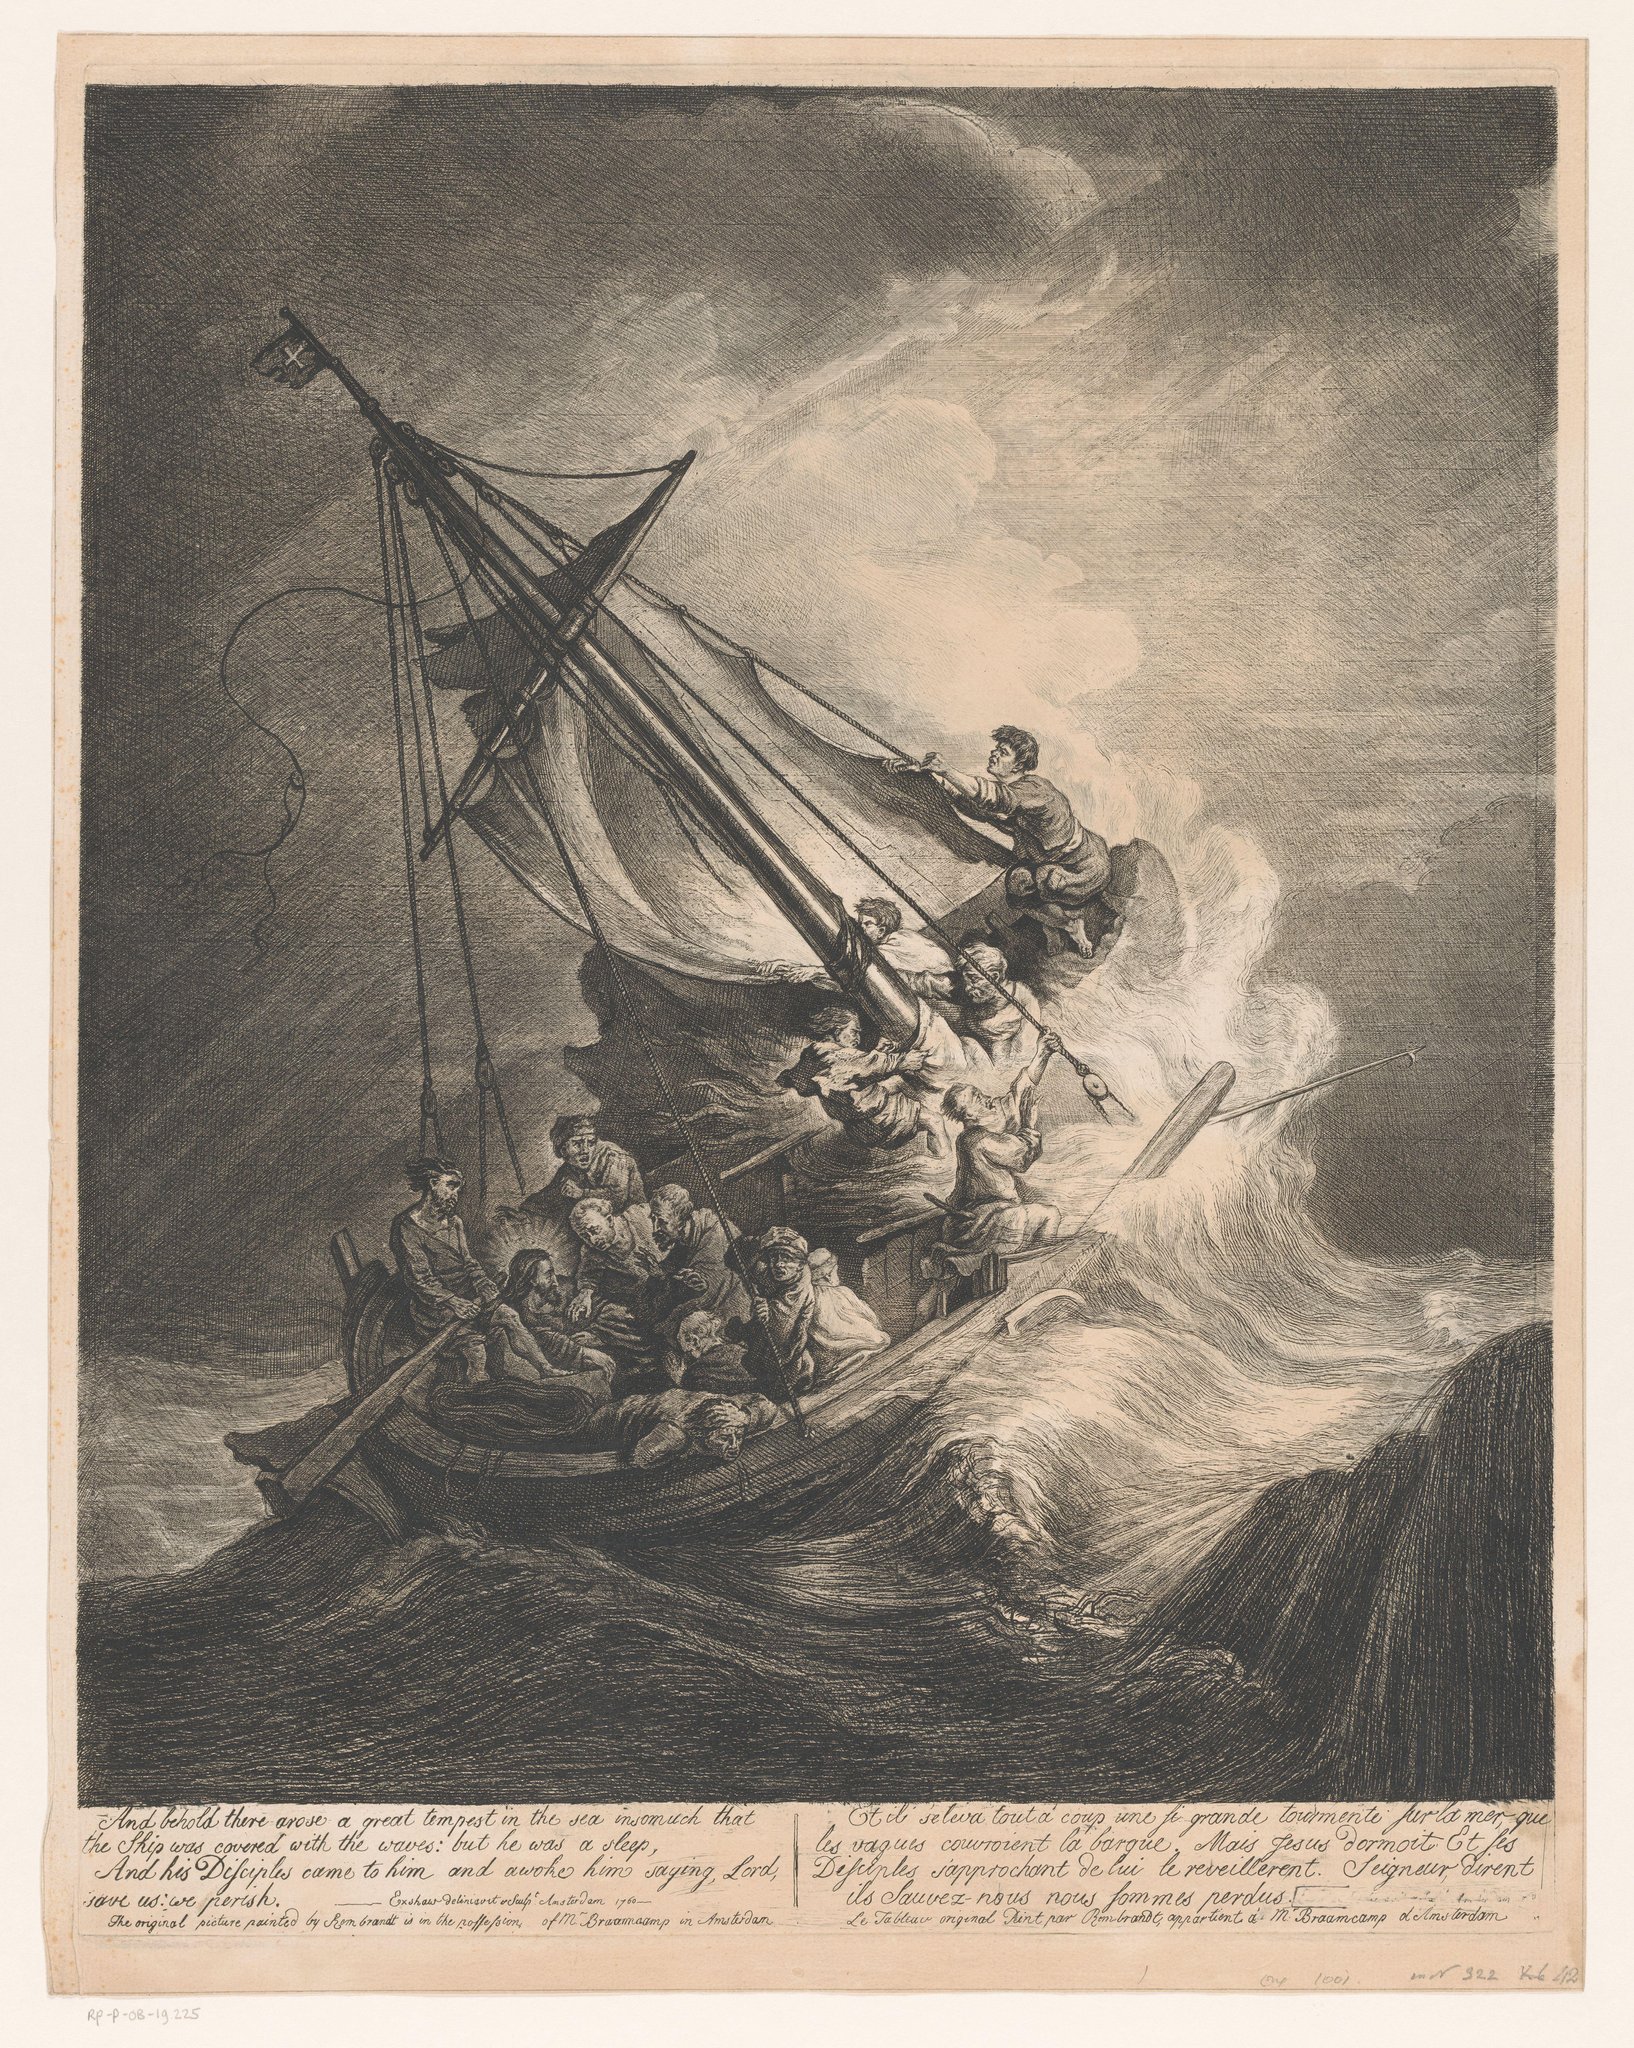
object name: print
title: Christus in de storm op het Meer van Galilea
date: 1760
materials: paper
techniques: drypoint, etching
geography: amsterdam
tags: christ in a boat with the apostles, talking or sleeping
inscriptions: collector's mark: Lugt 2228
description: Christus zit links op de boot en wordt gewekt uit zijn slaap door zijn discipelen. Met onderschrift in het Engels en Frans.